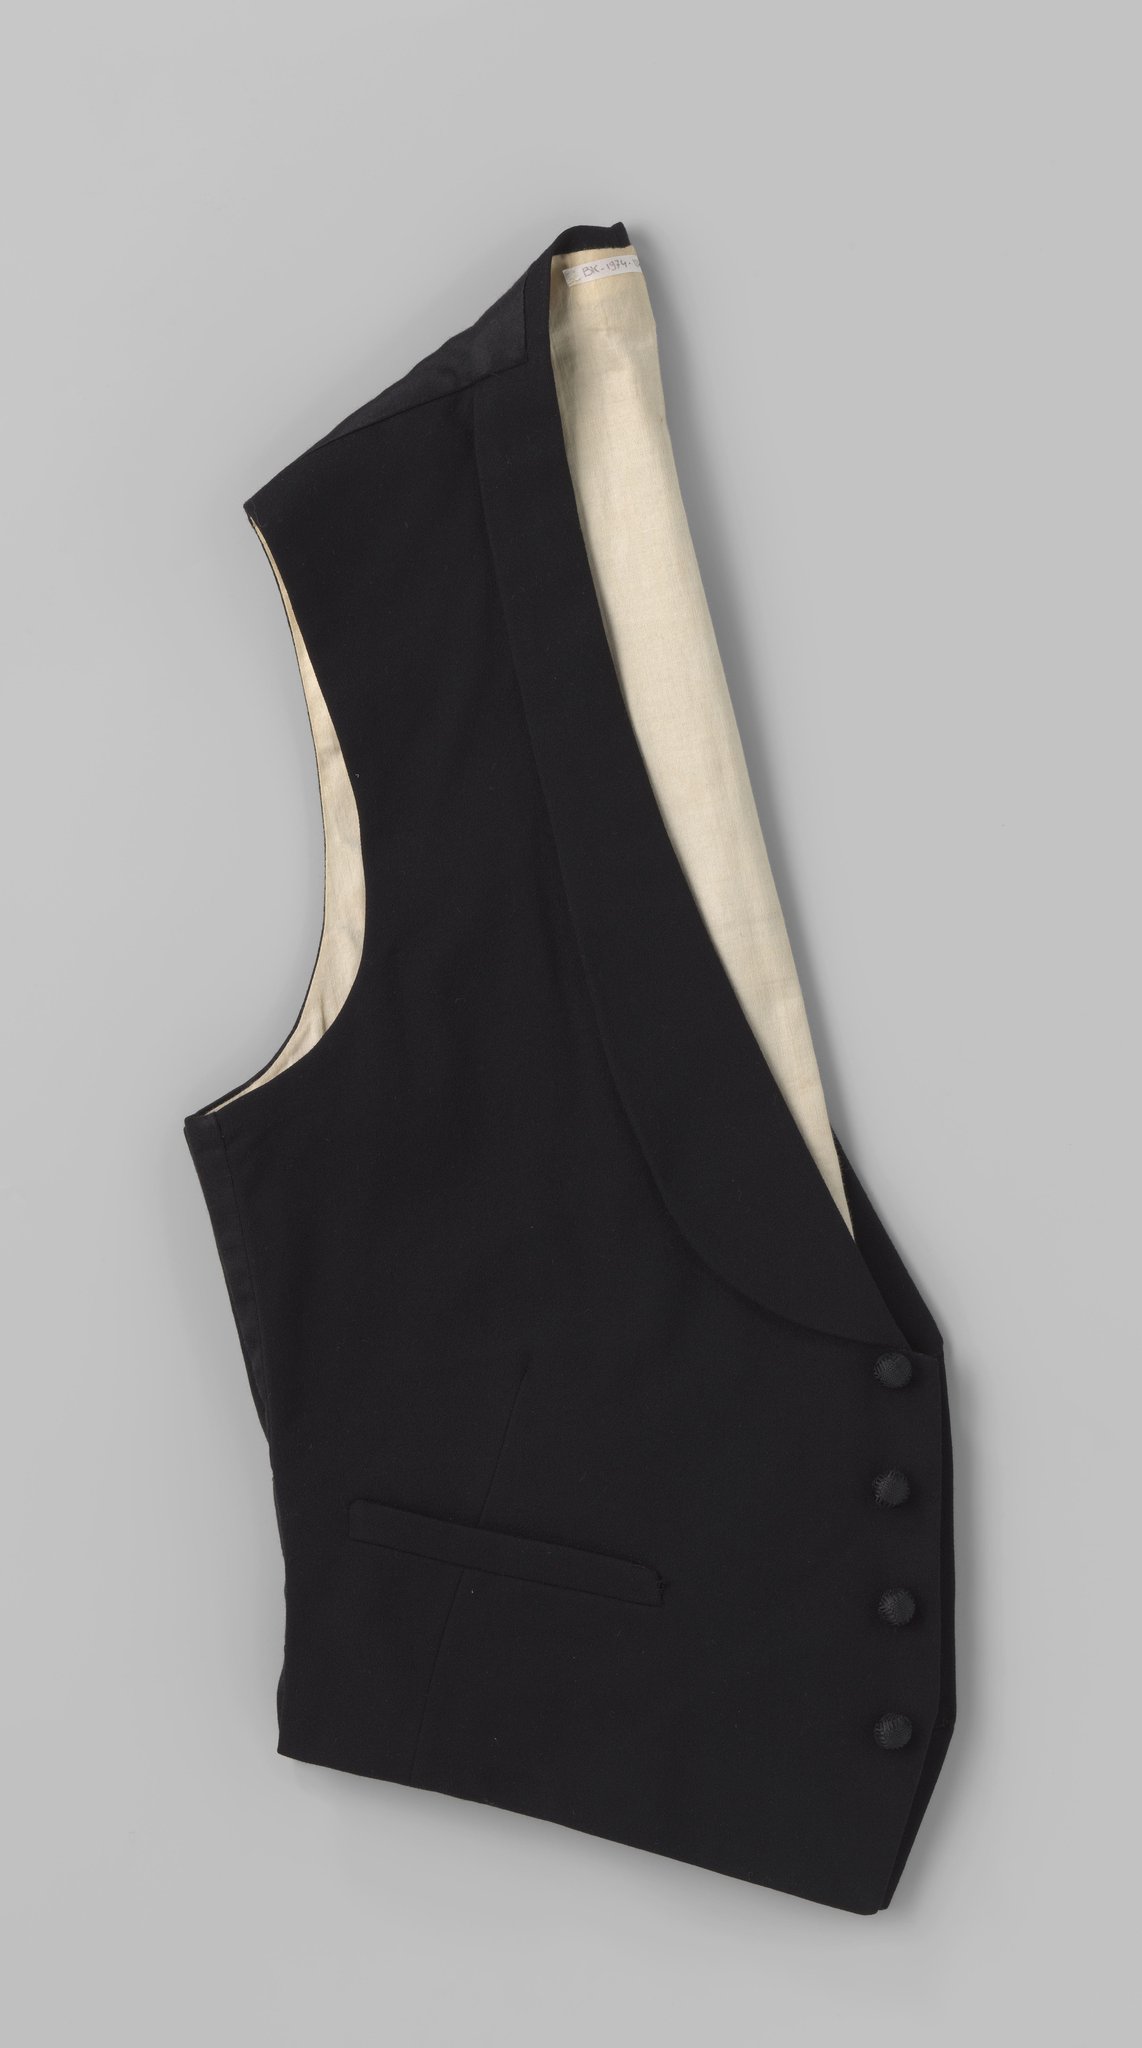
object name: main garment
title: Vest van zwart laken, onderdeel van smoking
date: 1929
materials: cotton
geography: zwolle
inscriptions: date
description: Vest van zwart laken, onderdeel van smoking. Korte en van onder recht gesneden panden. Mouwloos. Diepe, afgeronde shawlkraag. Twee horizontale steekzakjes. Eén enkele rij van vier bolle passementknopen.